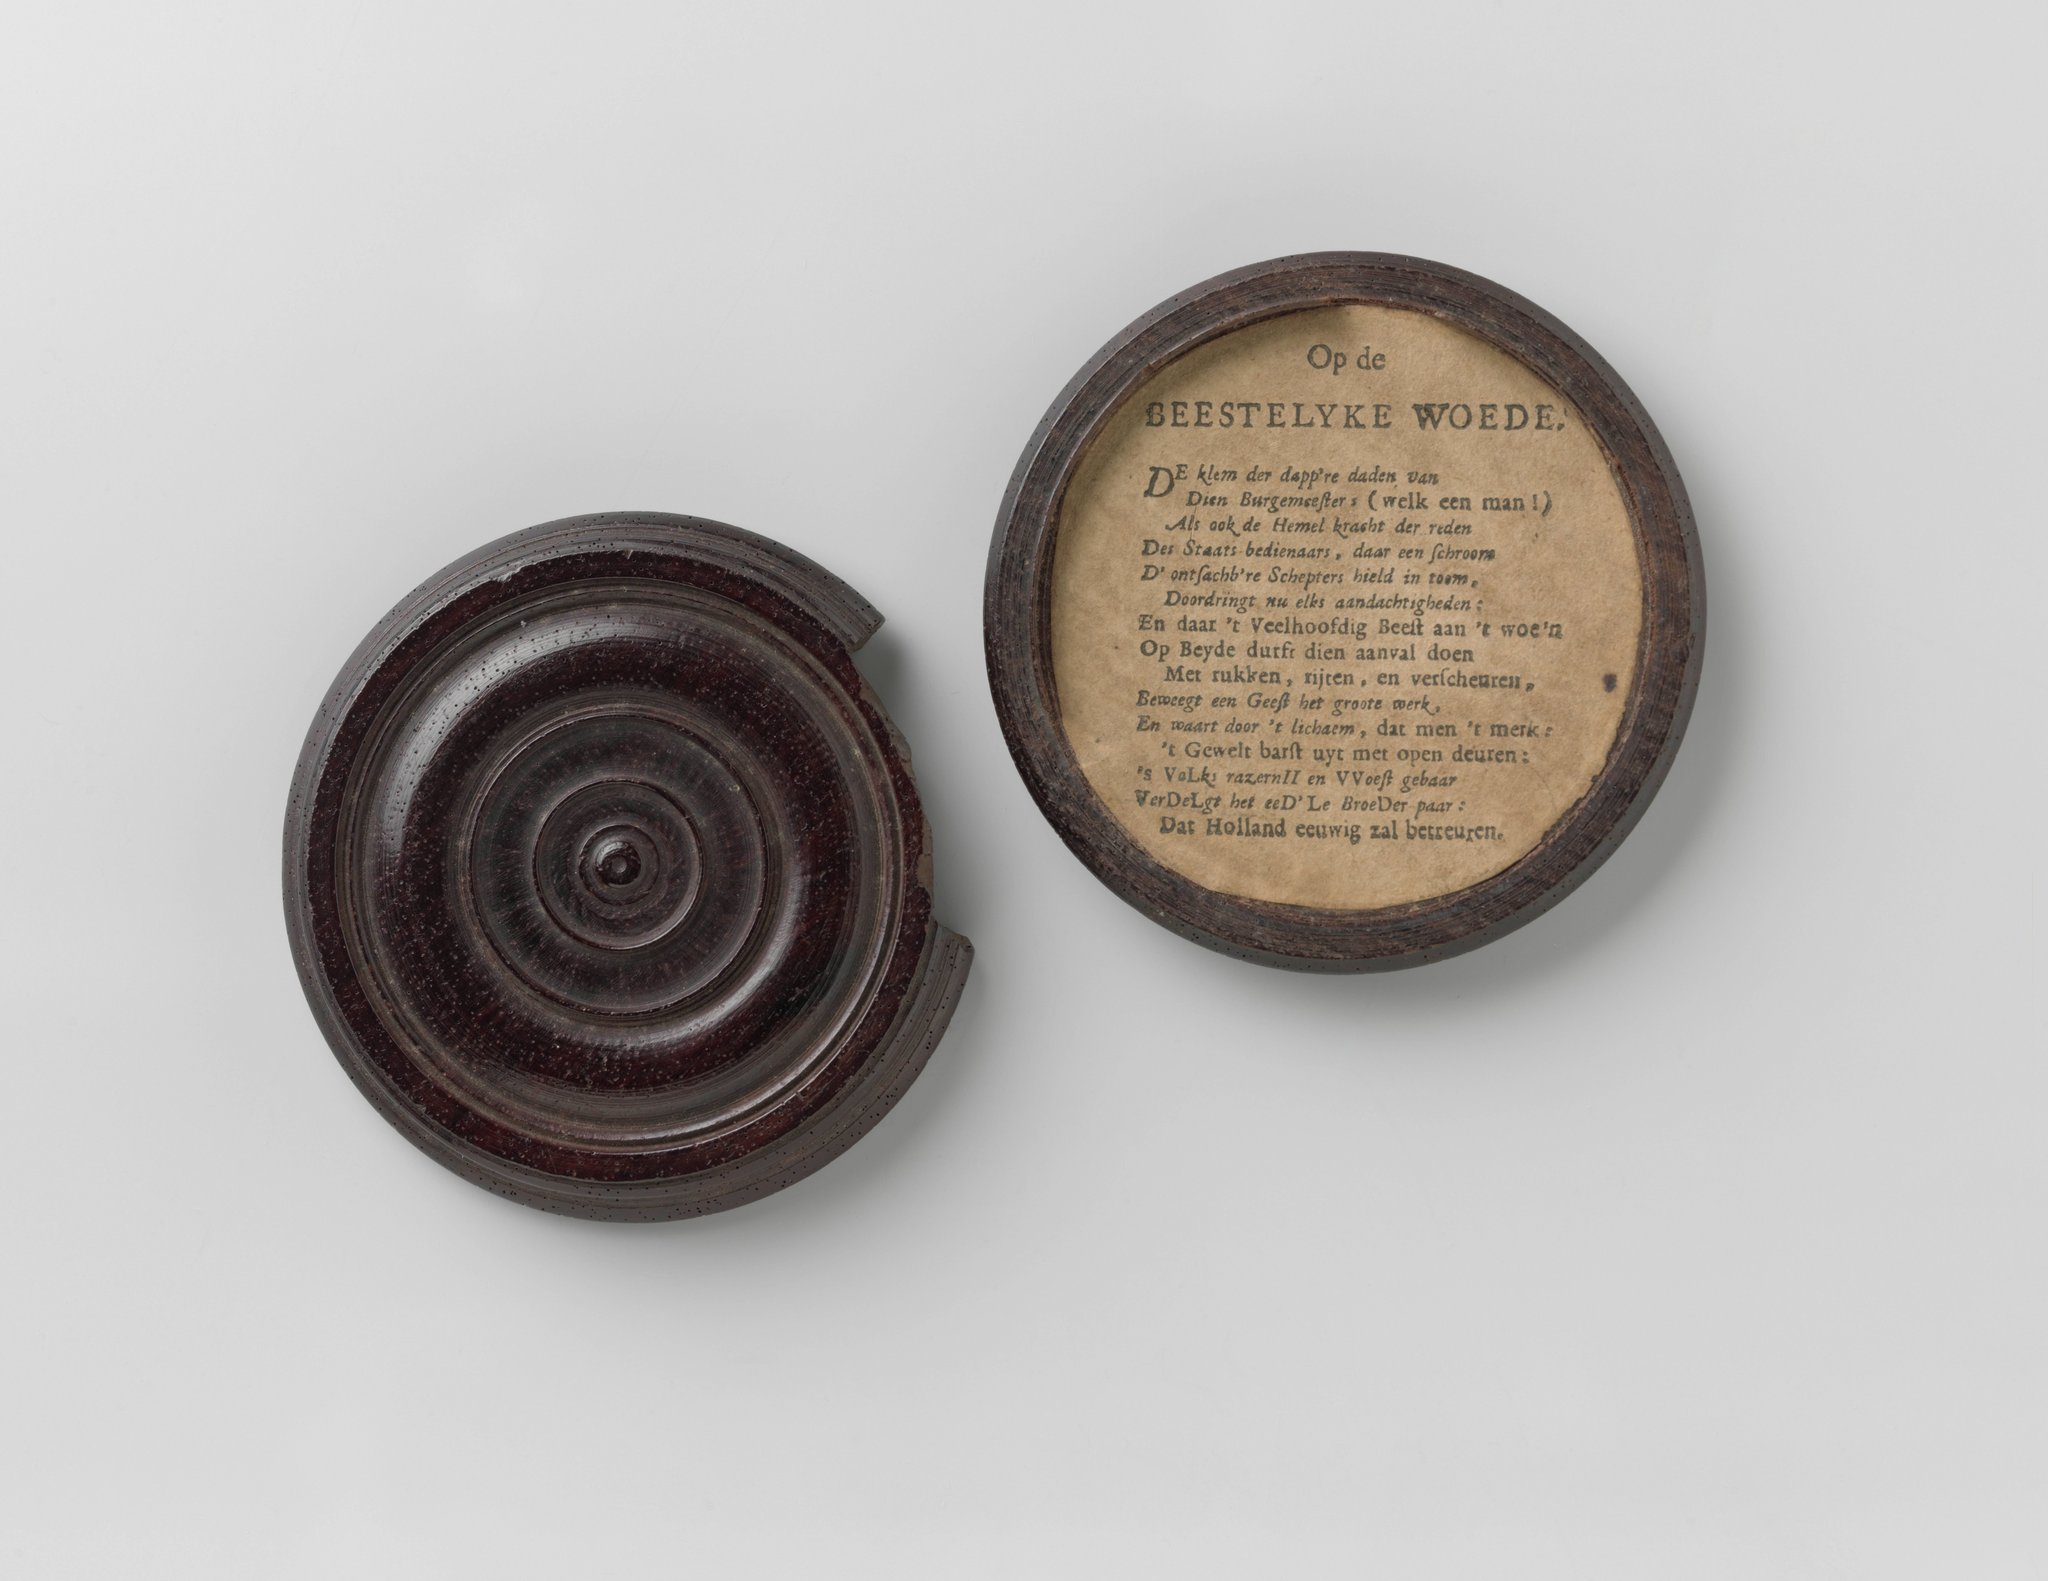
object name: medal box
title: Penningdoos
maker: Anonymous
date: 1672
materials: paper, wood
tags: the hague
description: Ronde palmhouten doos. In deksel hiervan papier met verklarende tekst bij gegraveerde afbeelding van de penning uit 't Swart Toneel Gordijn, 1677. Met bijbehorende penning NG-2014-3-1.